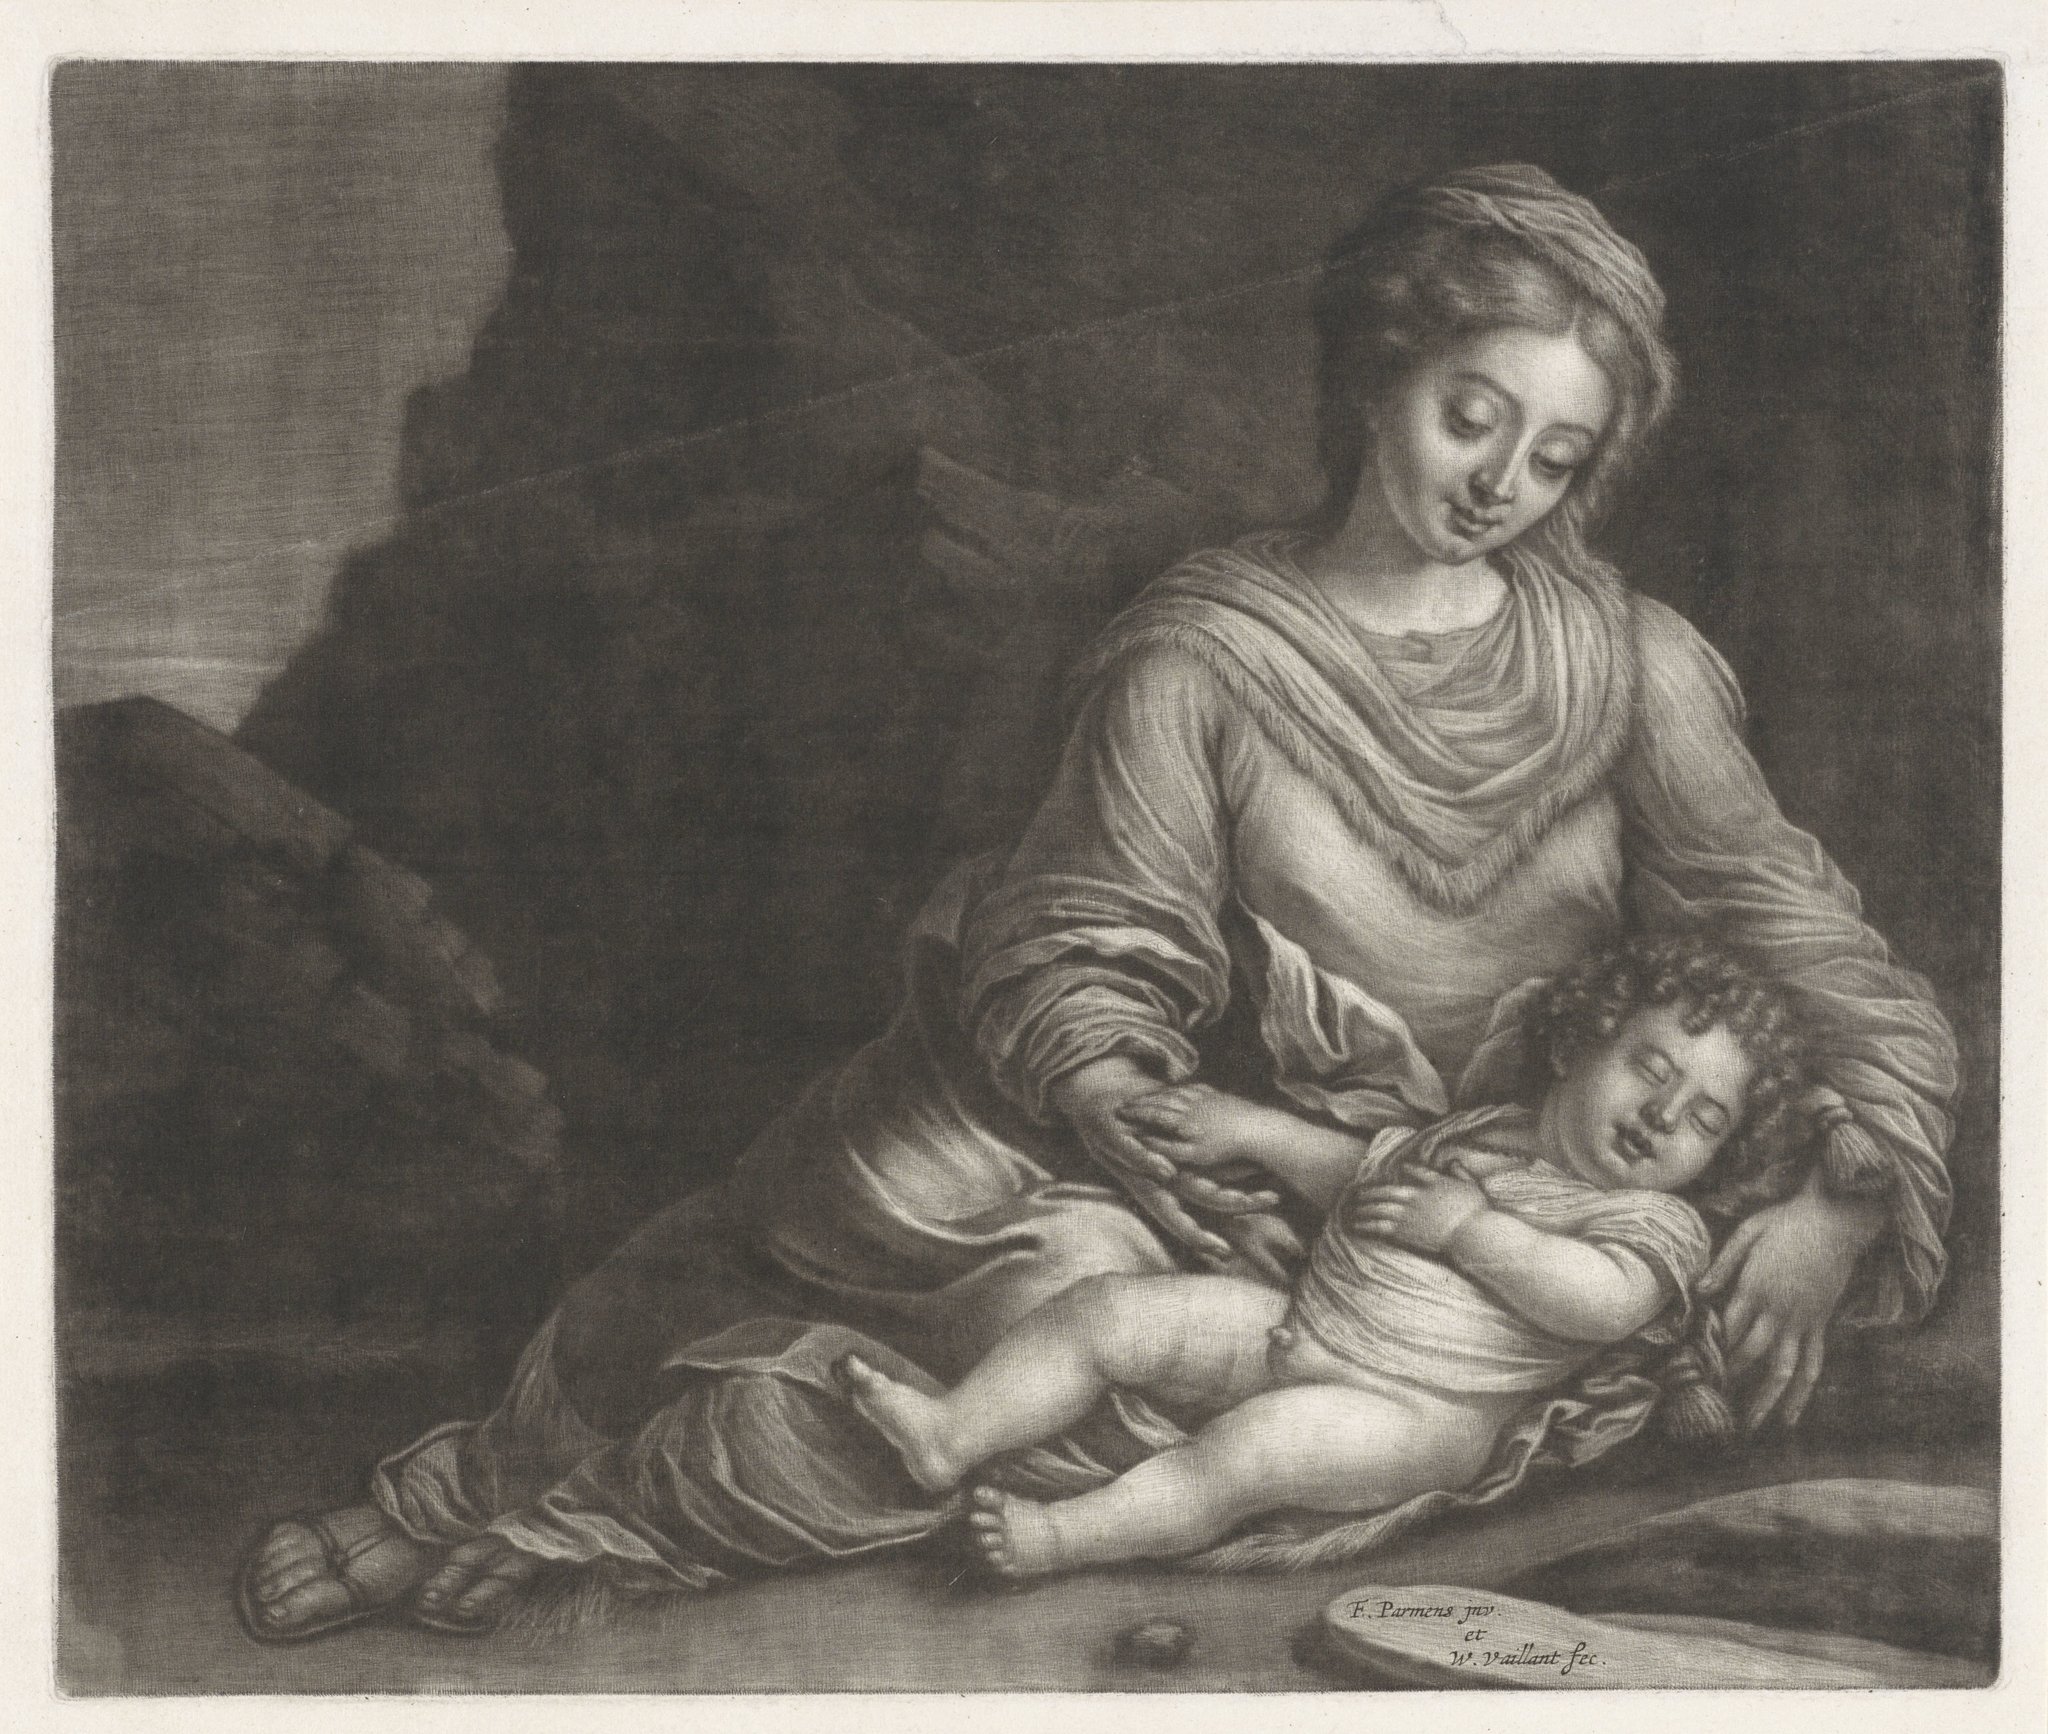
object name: print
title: Maria met het slapende Christuskind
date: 1658-1677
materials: paper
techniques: mezzotint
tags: madonna: mary sitting on the ground, the christ-child in her lap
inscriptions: collector's mark: Lugt 10, collector's mark: Lugt 11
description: In een rotslandschap zit Maria met het slapende Christuskind.